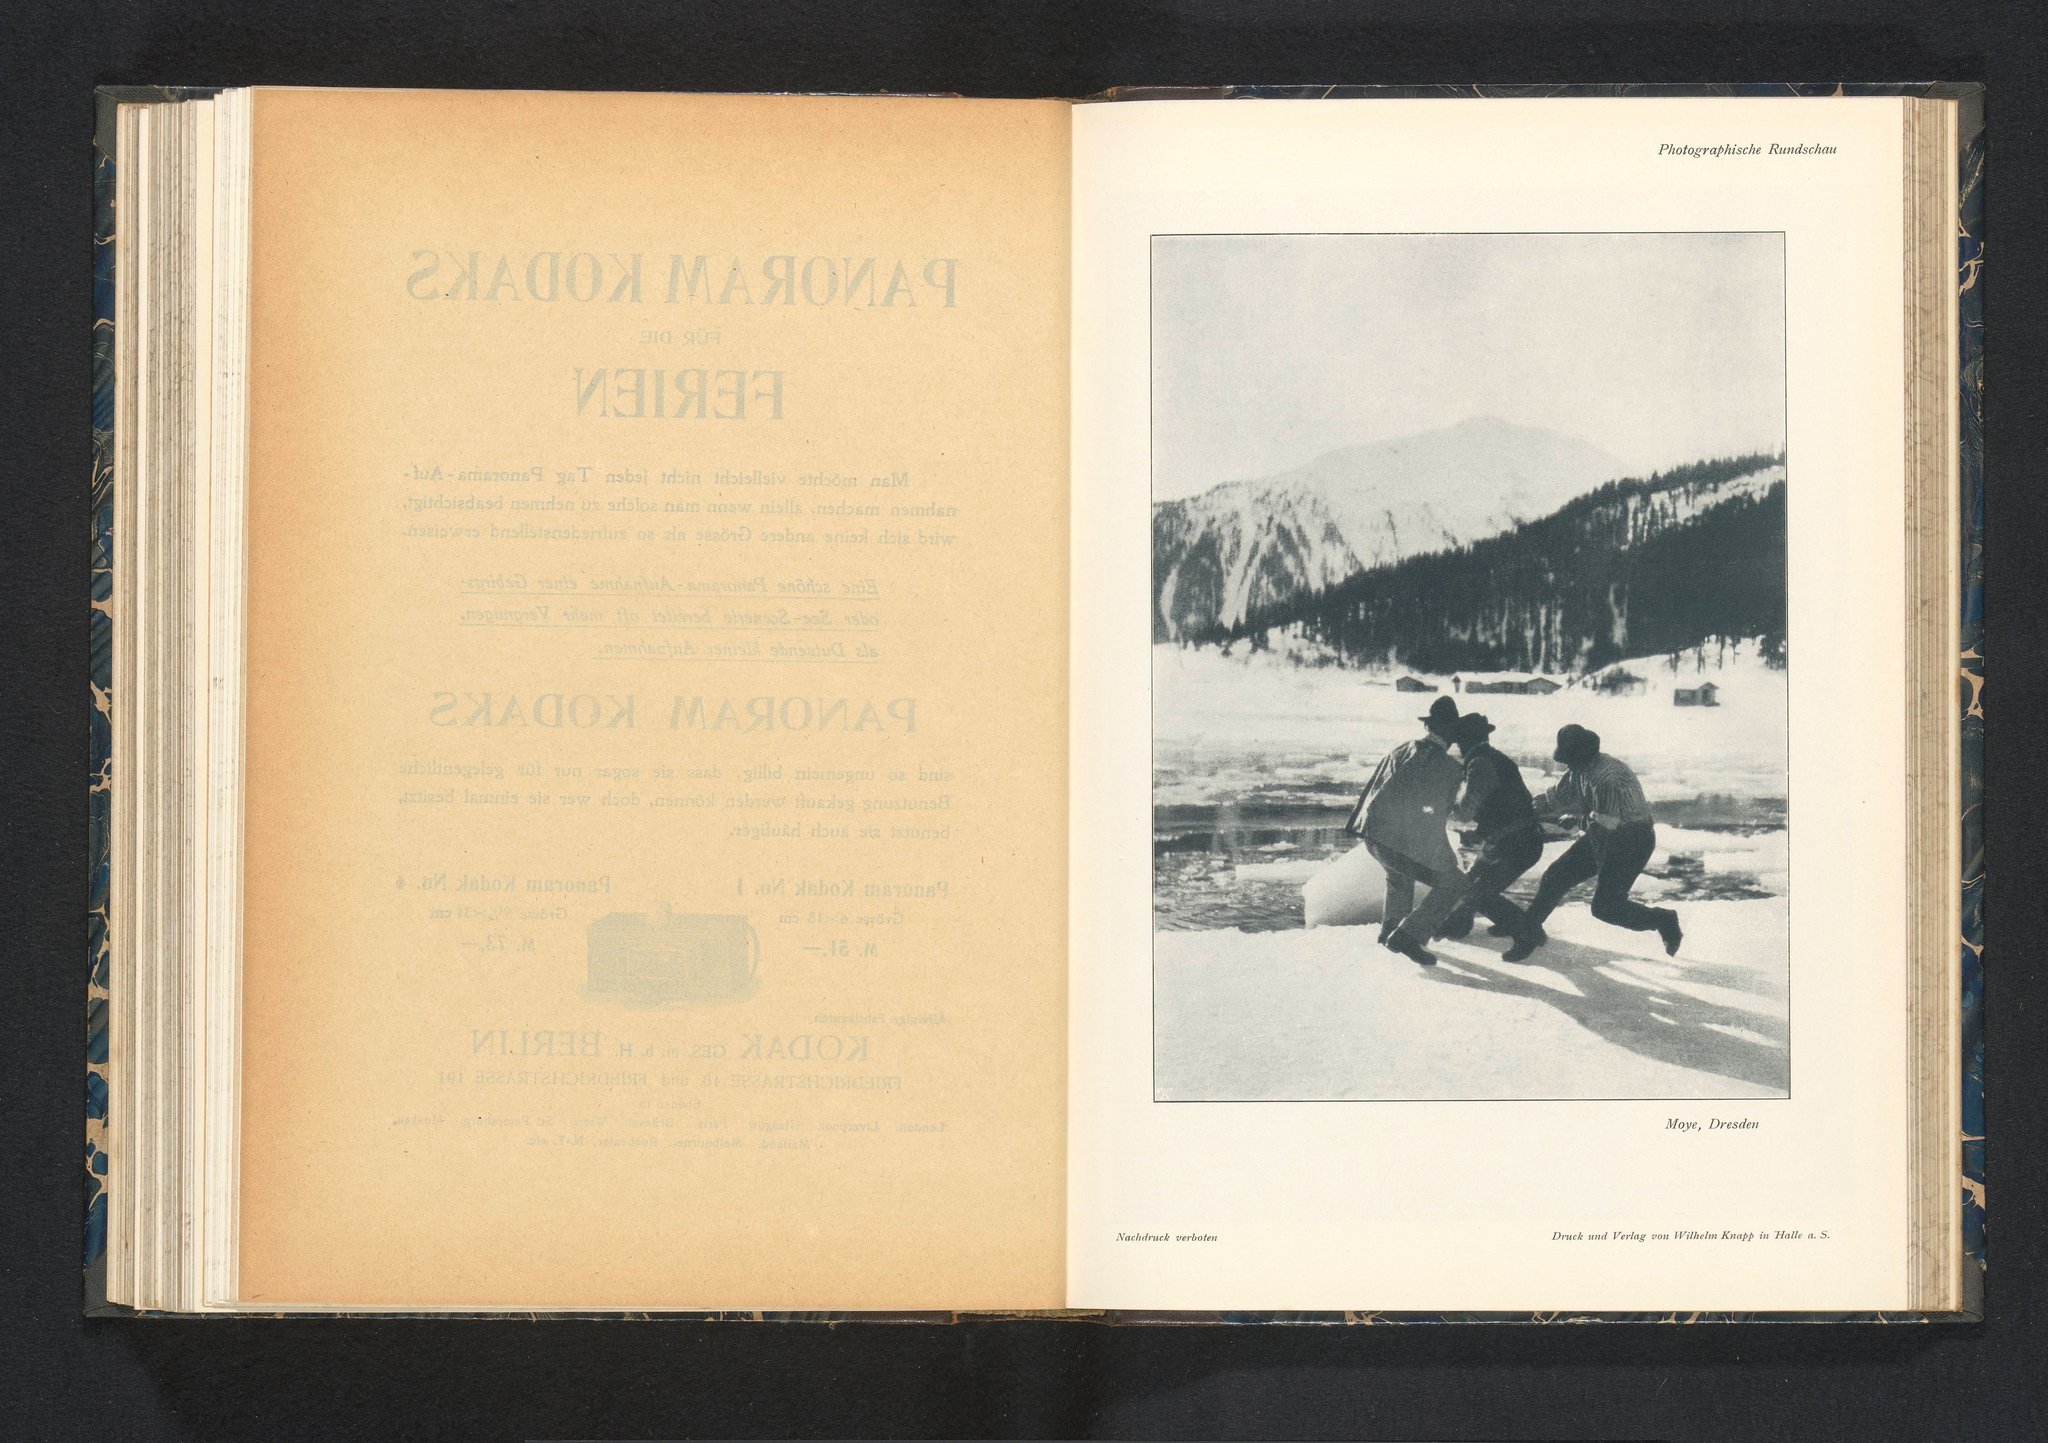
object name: page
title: Drie mannen trekken een ijsschots uit het water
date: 1896-1901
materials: paper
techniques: autotype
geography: halle an der saale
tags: adult man, ice ~ freezing weather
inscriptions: monogram: ‘Dr A Co’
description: Prent op vierde ongenummerde pagina na pagina 236.